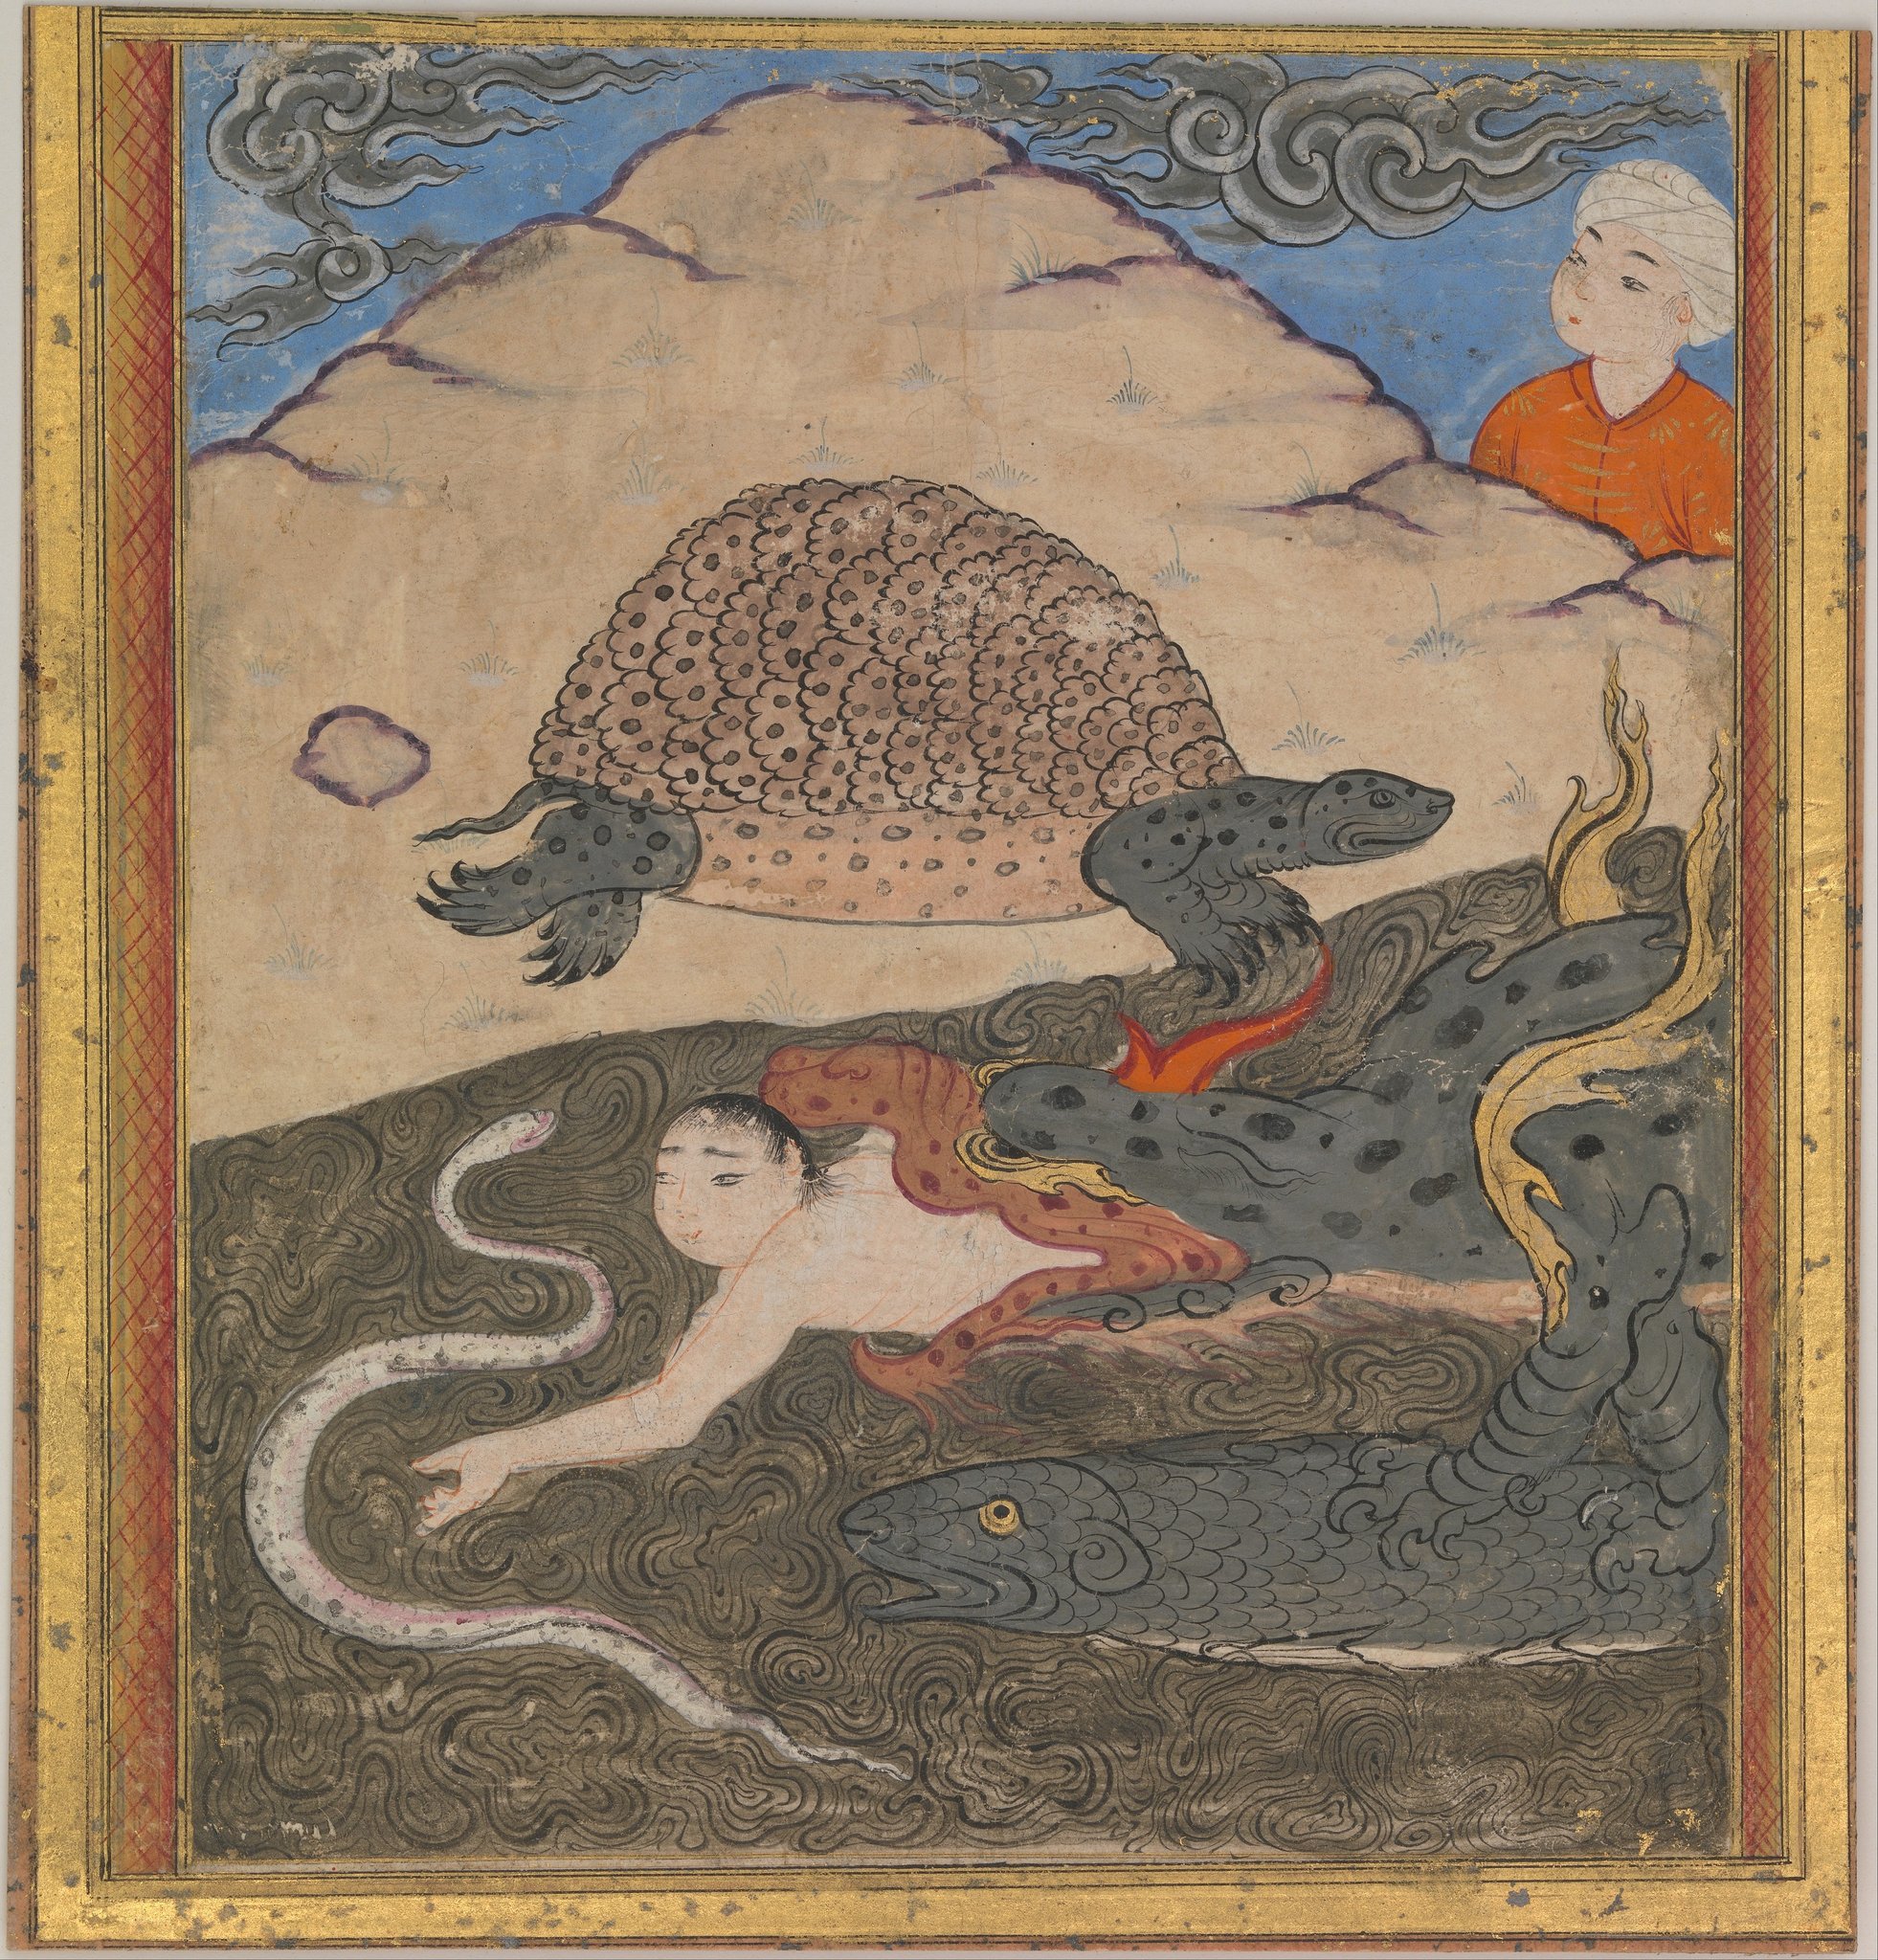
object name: folio from an illustrated manuscript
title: "The Tortoise", Folio from an `Aja'ib al-Makhluqat (Wonders of Creation) of Qazwini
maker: zakaria bin muhammad bin mahmud abu yahya qazwini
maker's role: author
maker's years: 1198-1283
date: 1551-1600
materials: gold, paper, watercolor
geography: iran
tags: men,crocodiles,fish,snakes,turtles